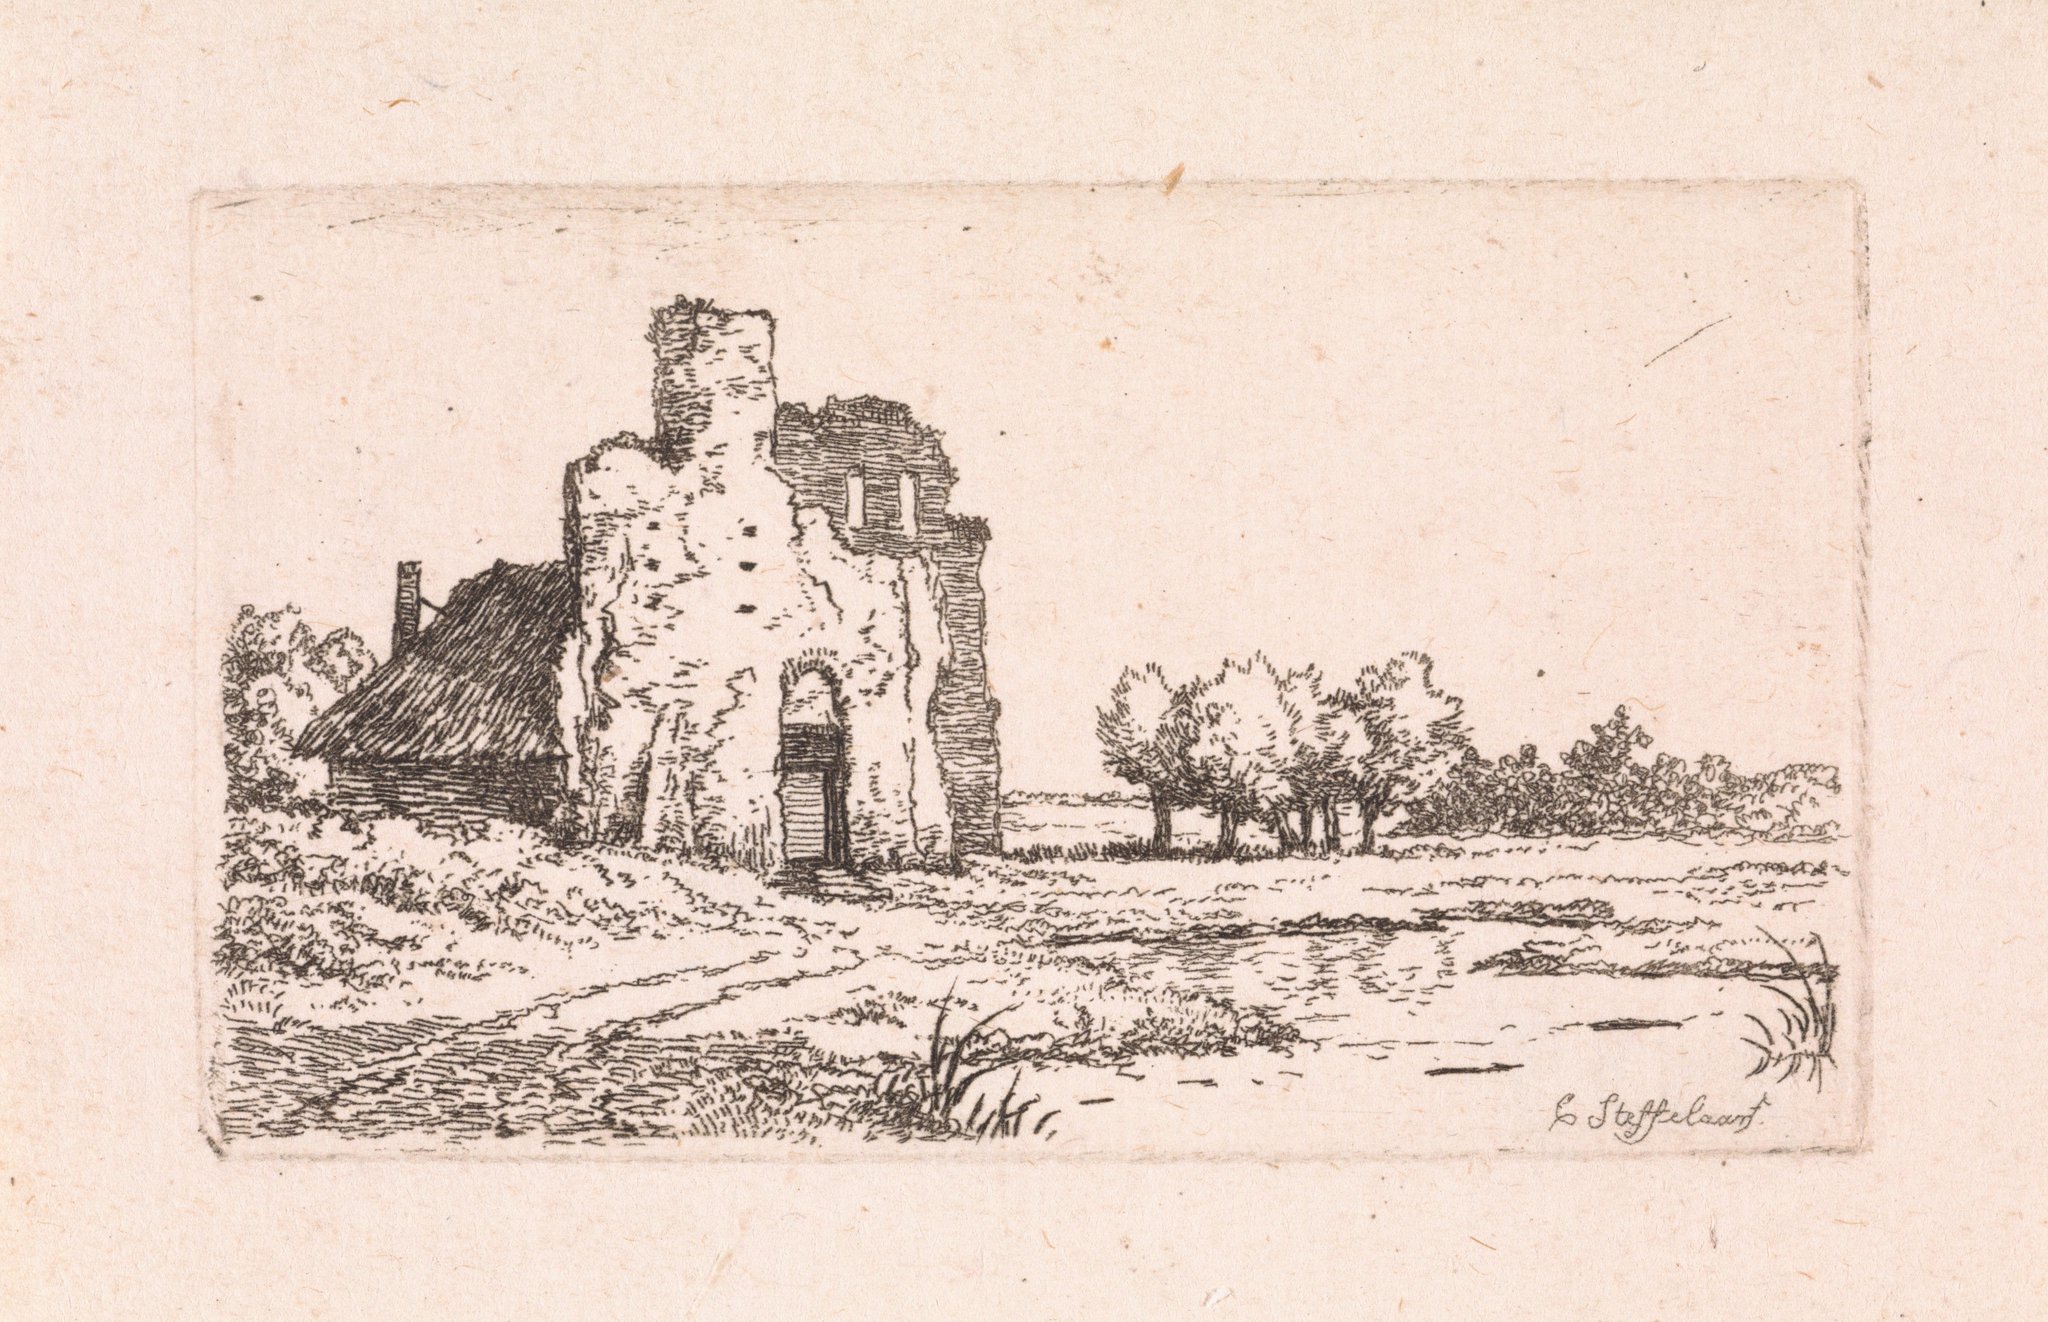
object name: print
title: Tweede suite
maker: cornelis steffelaar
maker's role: draughtsman, painter, print maker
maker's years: 1797-1861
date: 1845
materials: paper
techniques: etching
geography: amsterdam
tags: landscape with ruins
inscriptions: collector's mark: Lugt 2227